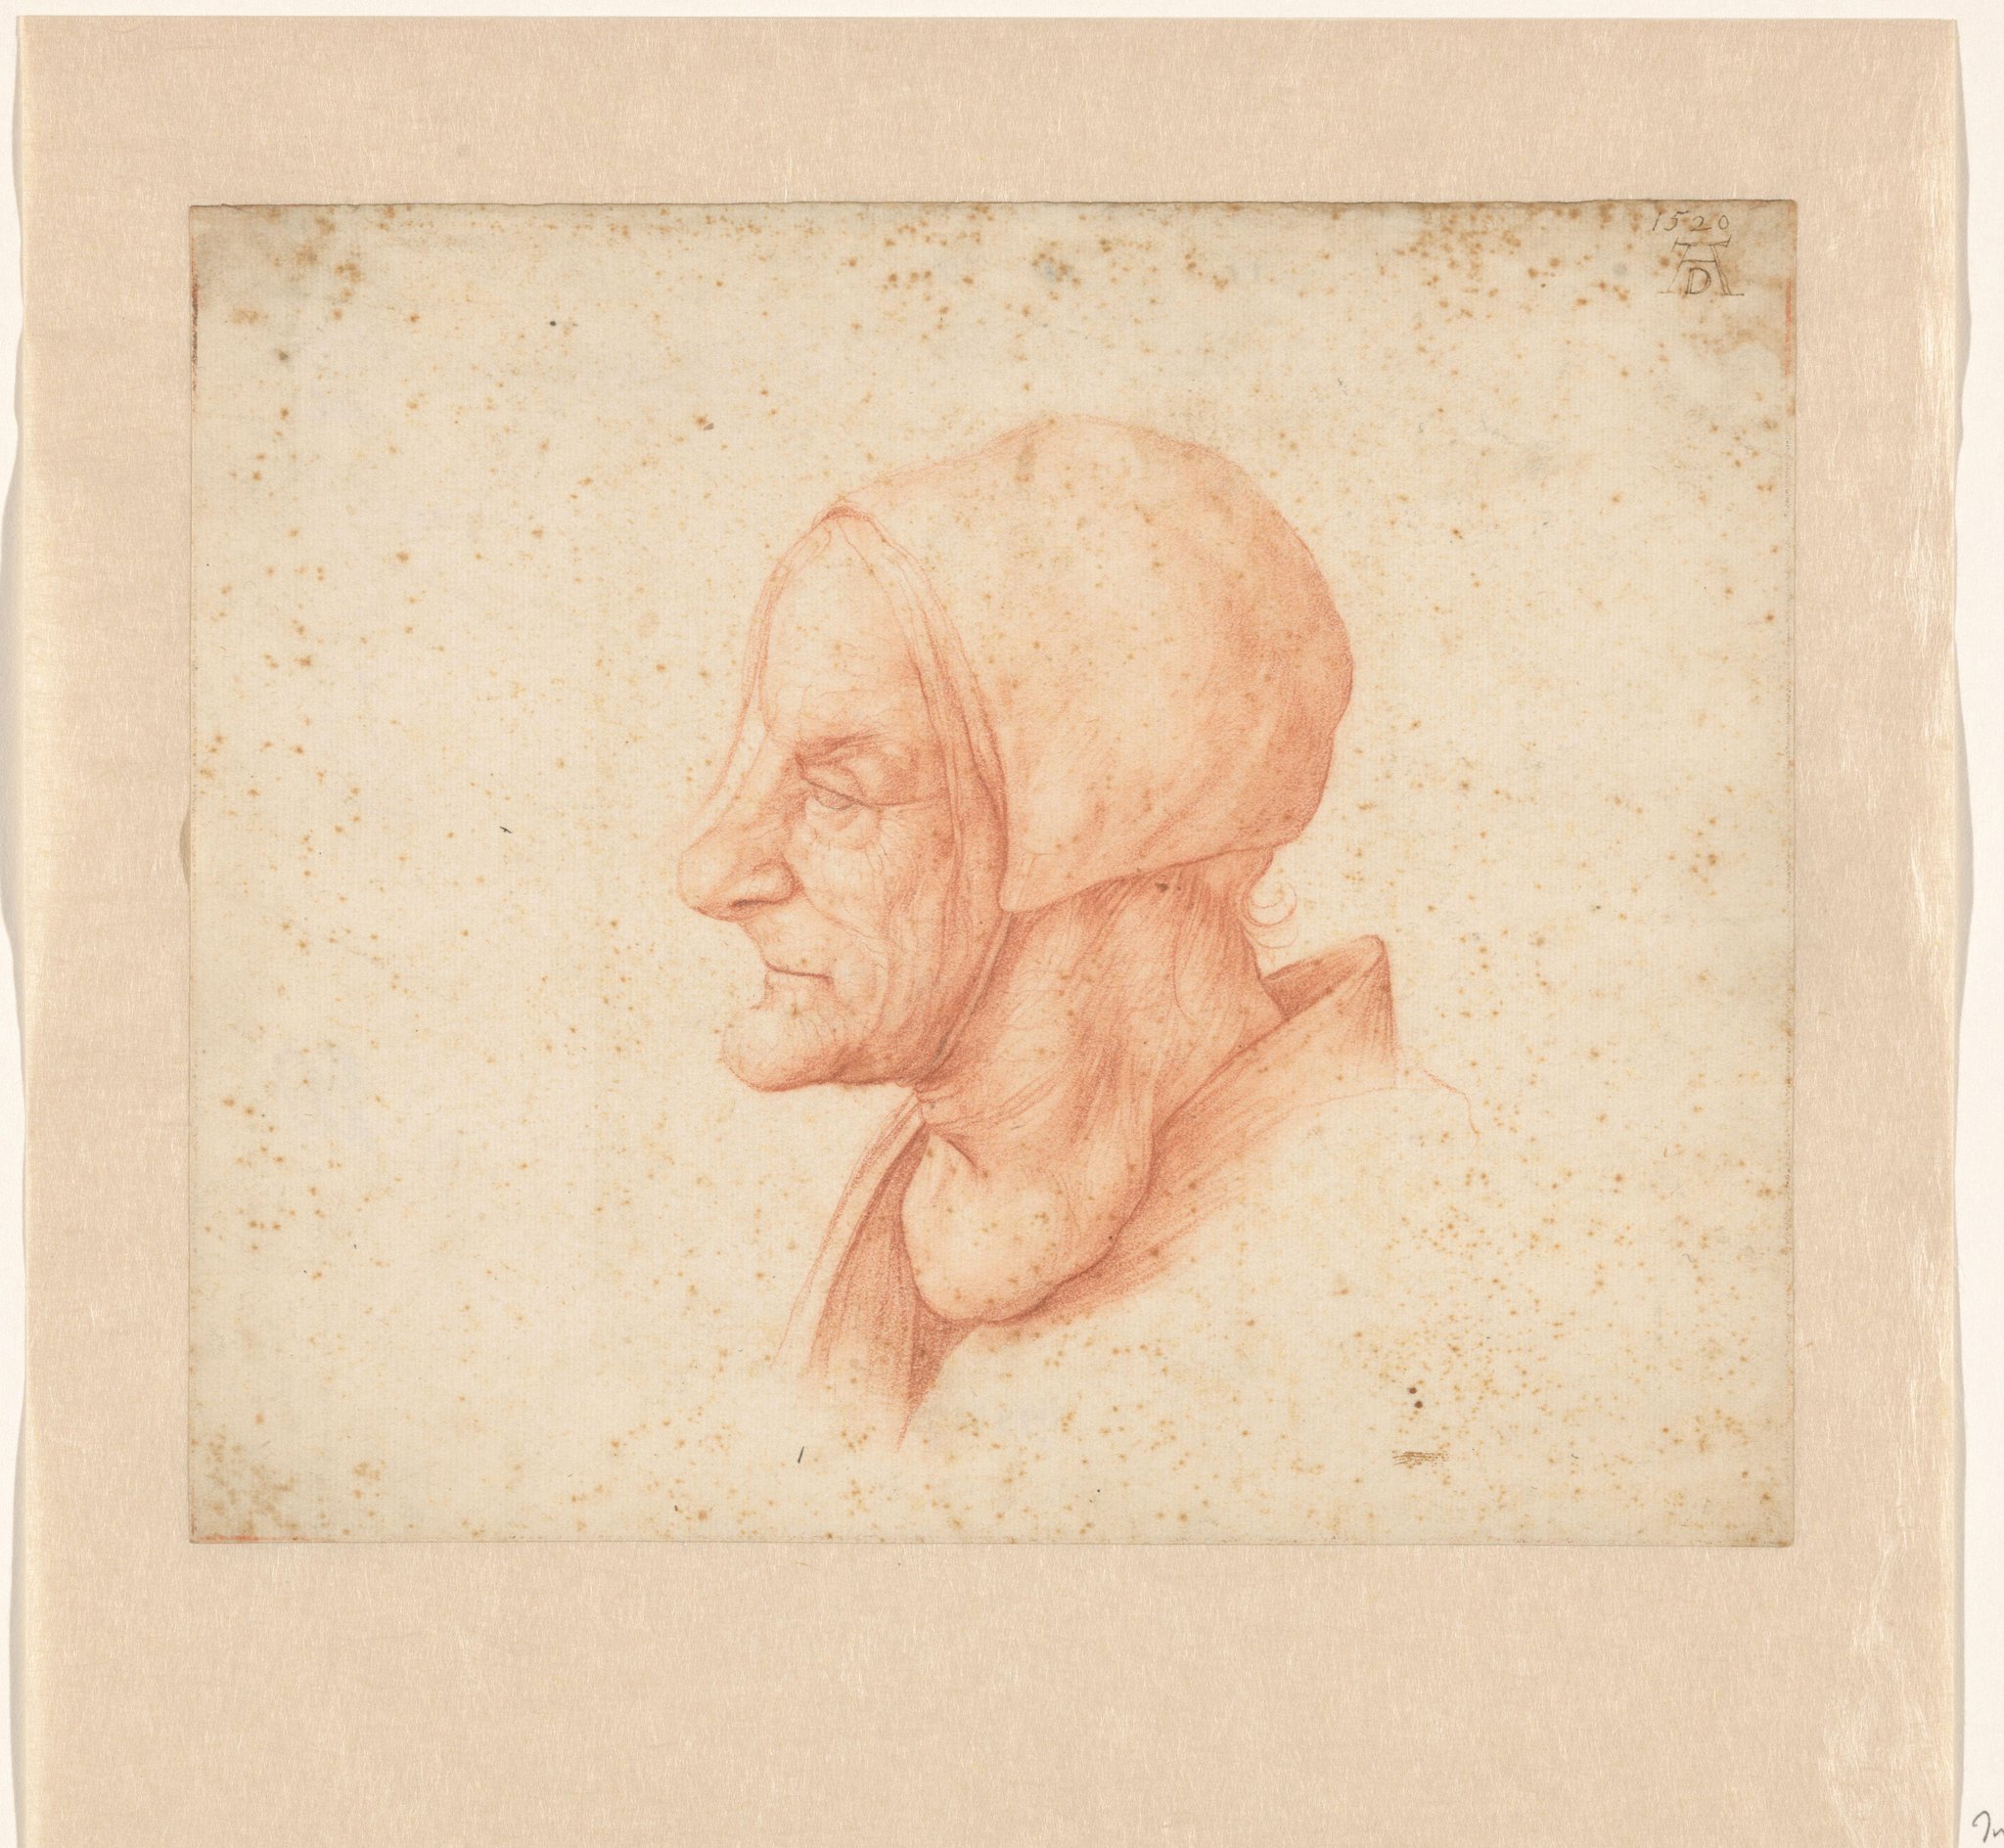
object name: drawing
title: Kop van een oude vrouw met een kropgezwel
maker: Anonymous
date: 1600-1699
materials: chalk, paper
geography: germany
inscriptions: monogram and date: ‘1520 / AD’